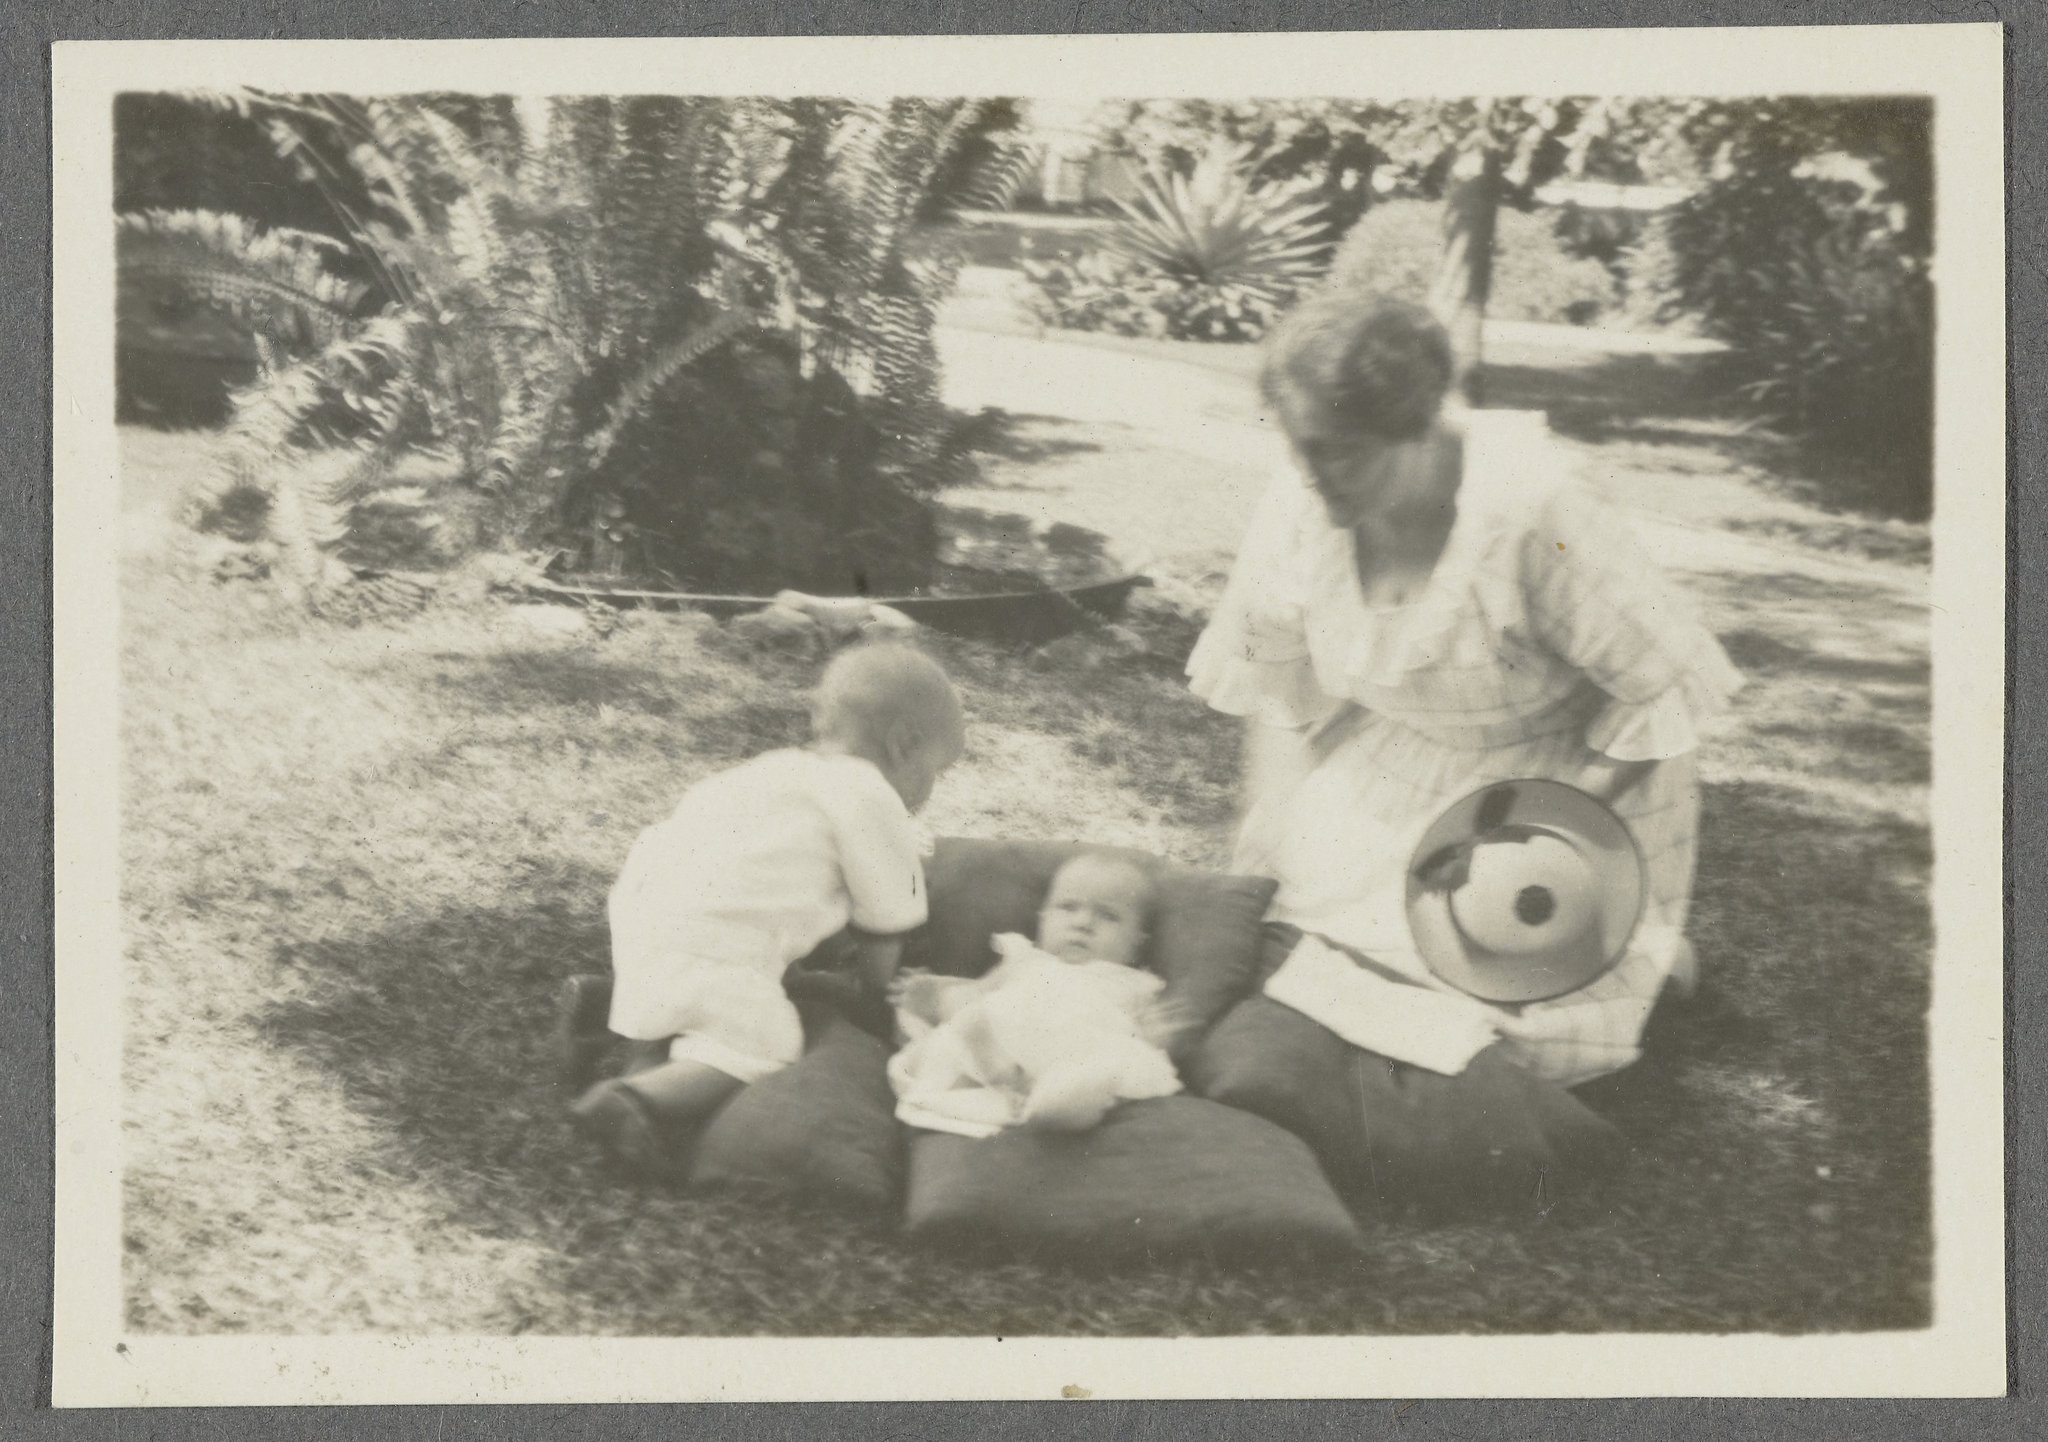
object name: photograph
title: Tine Kleiterp-Vermeulen en haar kinderen Klaas en Tiny in een tuin in Pangka op Java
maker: klaas kleiterp (i)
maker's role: arts, officier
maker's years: 1892-1943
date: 1921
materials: paper, photographic support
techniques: daylight paper print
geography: pangka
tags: garden, mother and baby or young child, dutch east indies, the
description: Onderdeel van Fotoalbum van de familie Kleiterp-Vermeulen met opnames van de kinderen Klaas en Tiny in Nederlands-Indië.